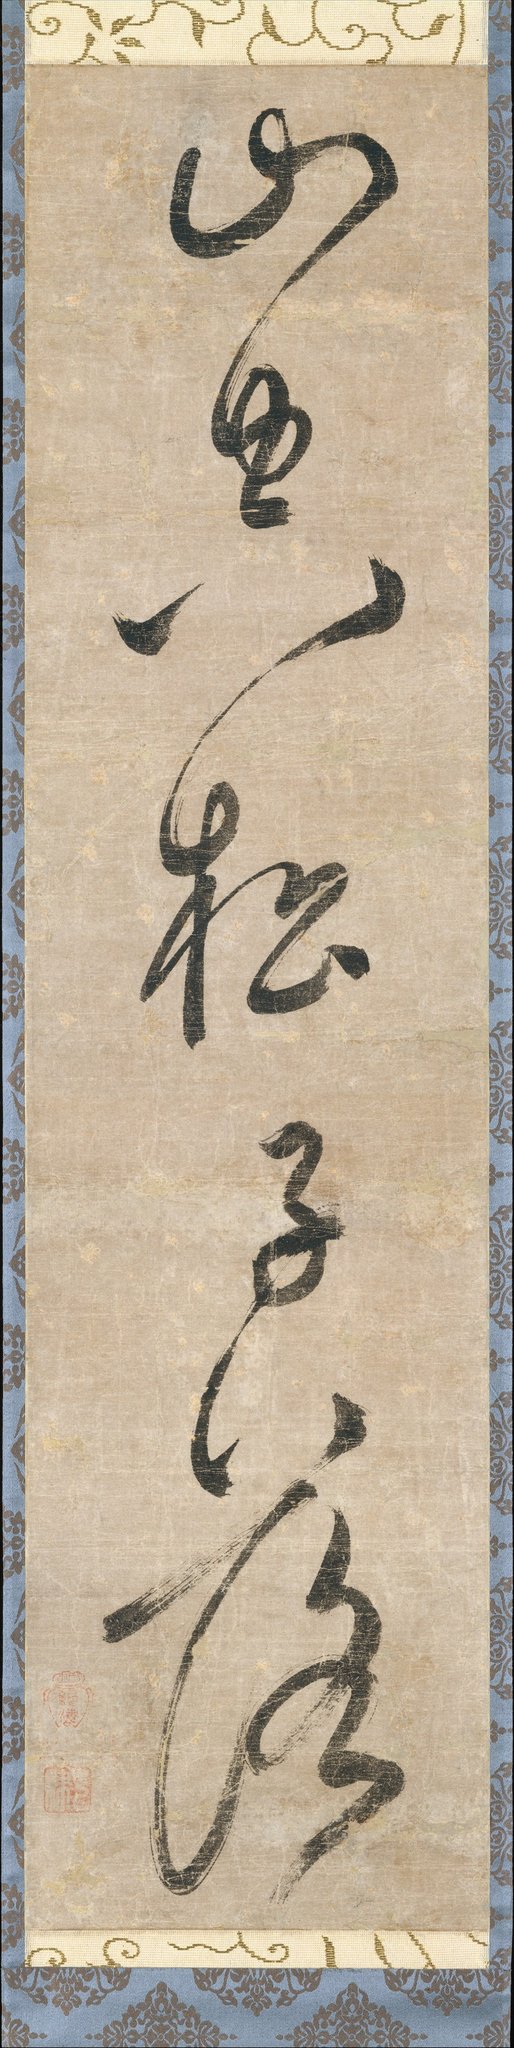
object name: hanging scroll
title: “The Mountain is Empty; A Pinecone Falls”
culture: japanese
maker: zekkai chūshin 絶海中津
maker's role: artist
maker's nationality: japanese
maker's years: 1336-1405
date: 1367-1400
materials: ink, paper